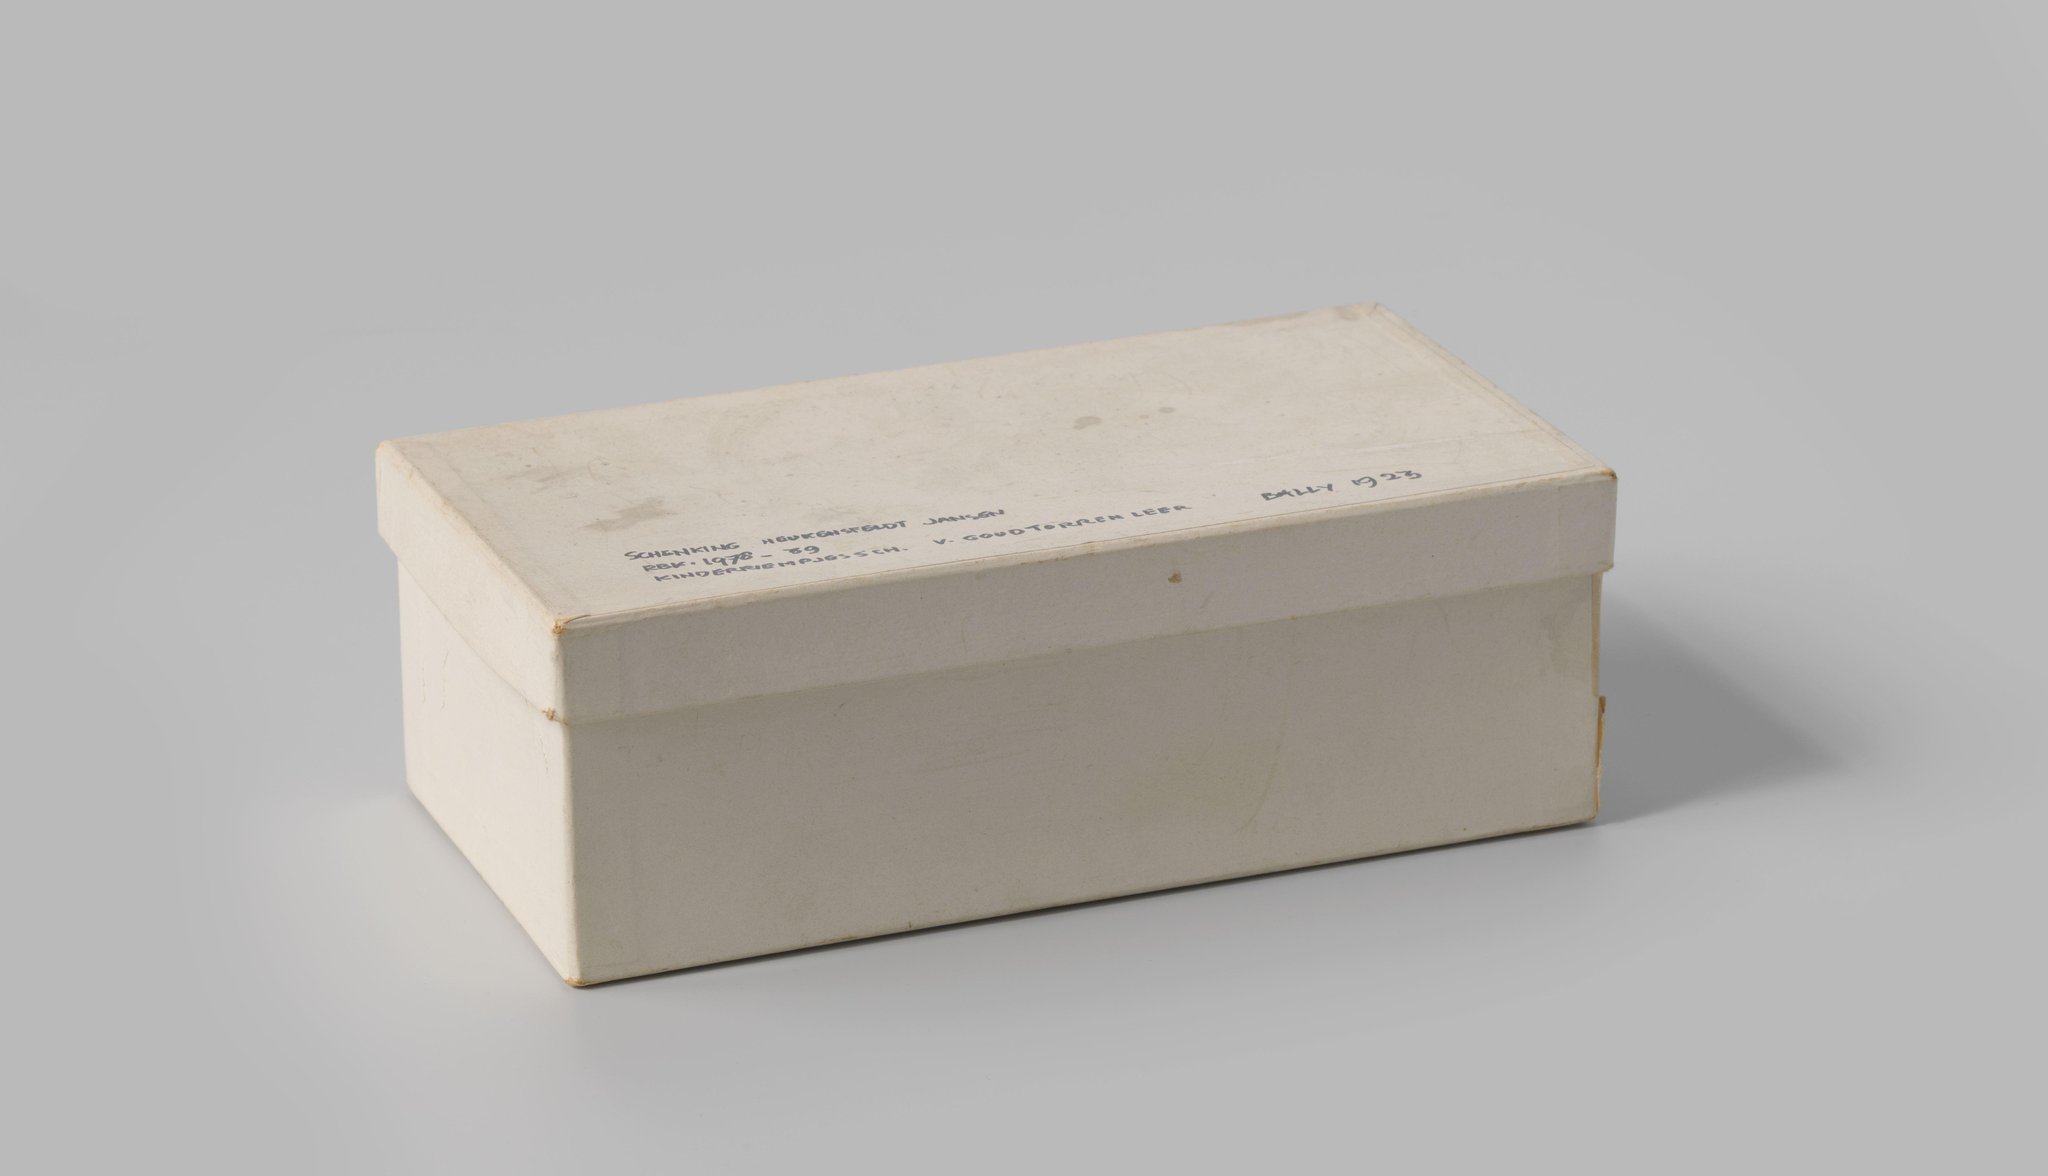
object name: verpakking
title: Witte schoenendoos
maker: h.w. schouten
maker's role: winkelier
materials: cardboard, paper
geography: amsterdam